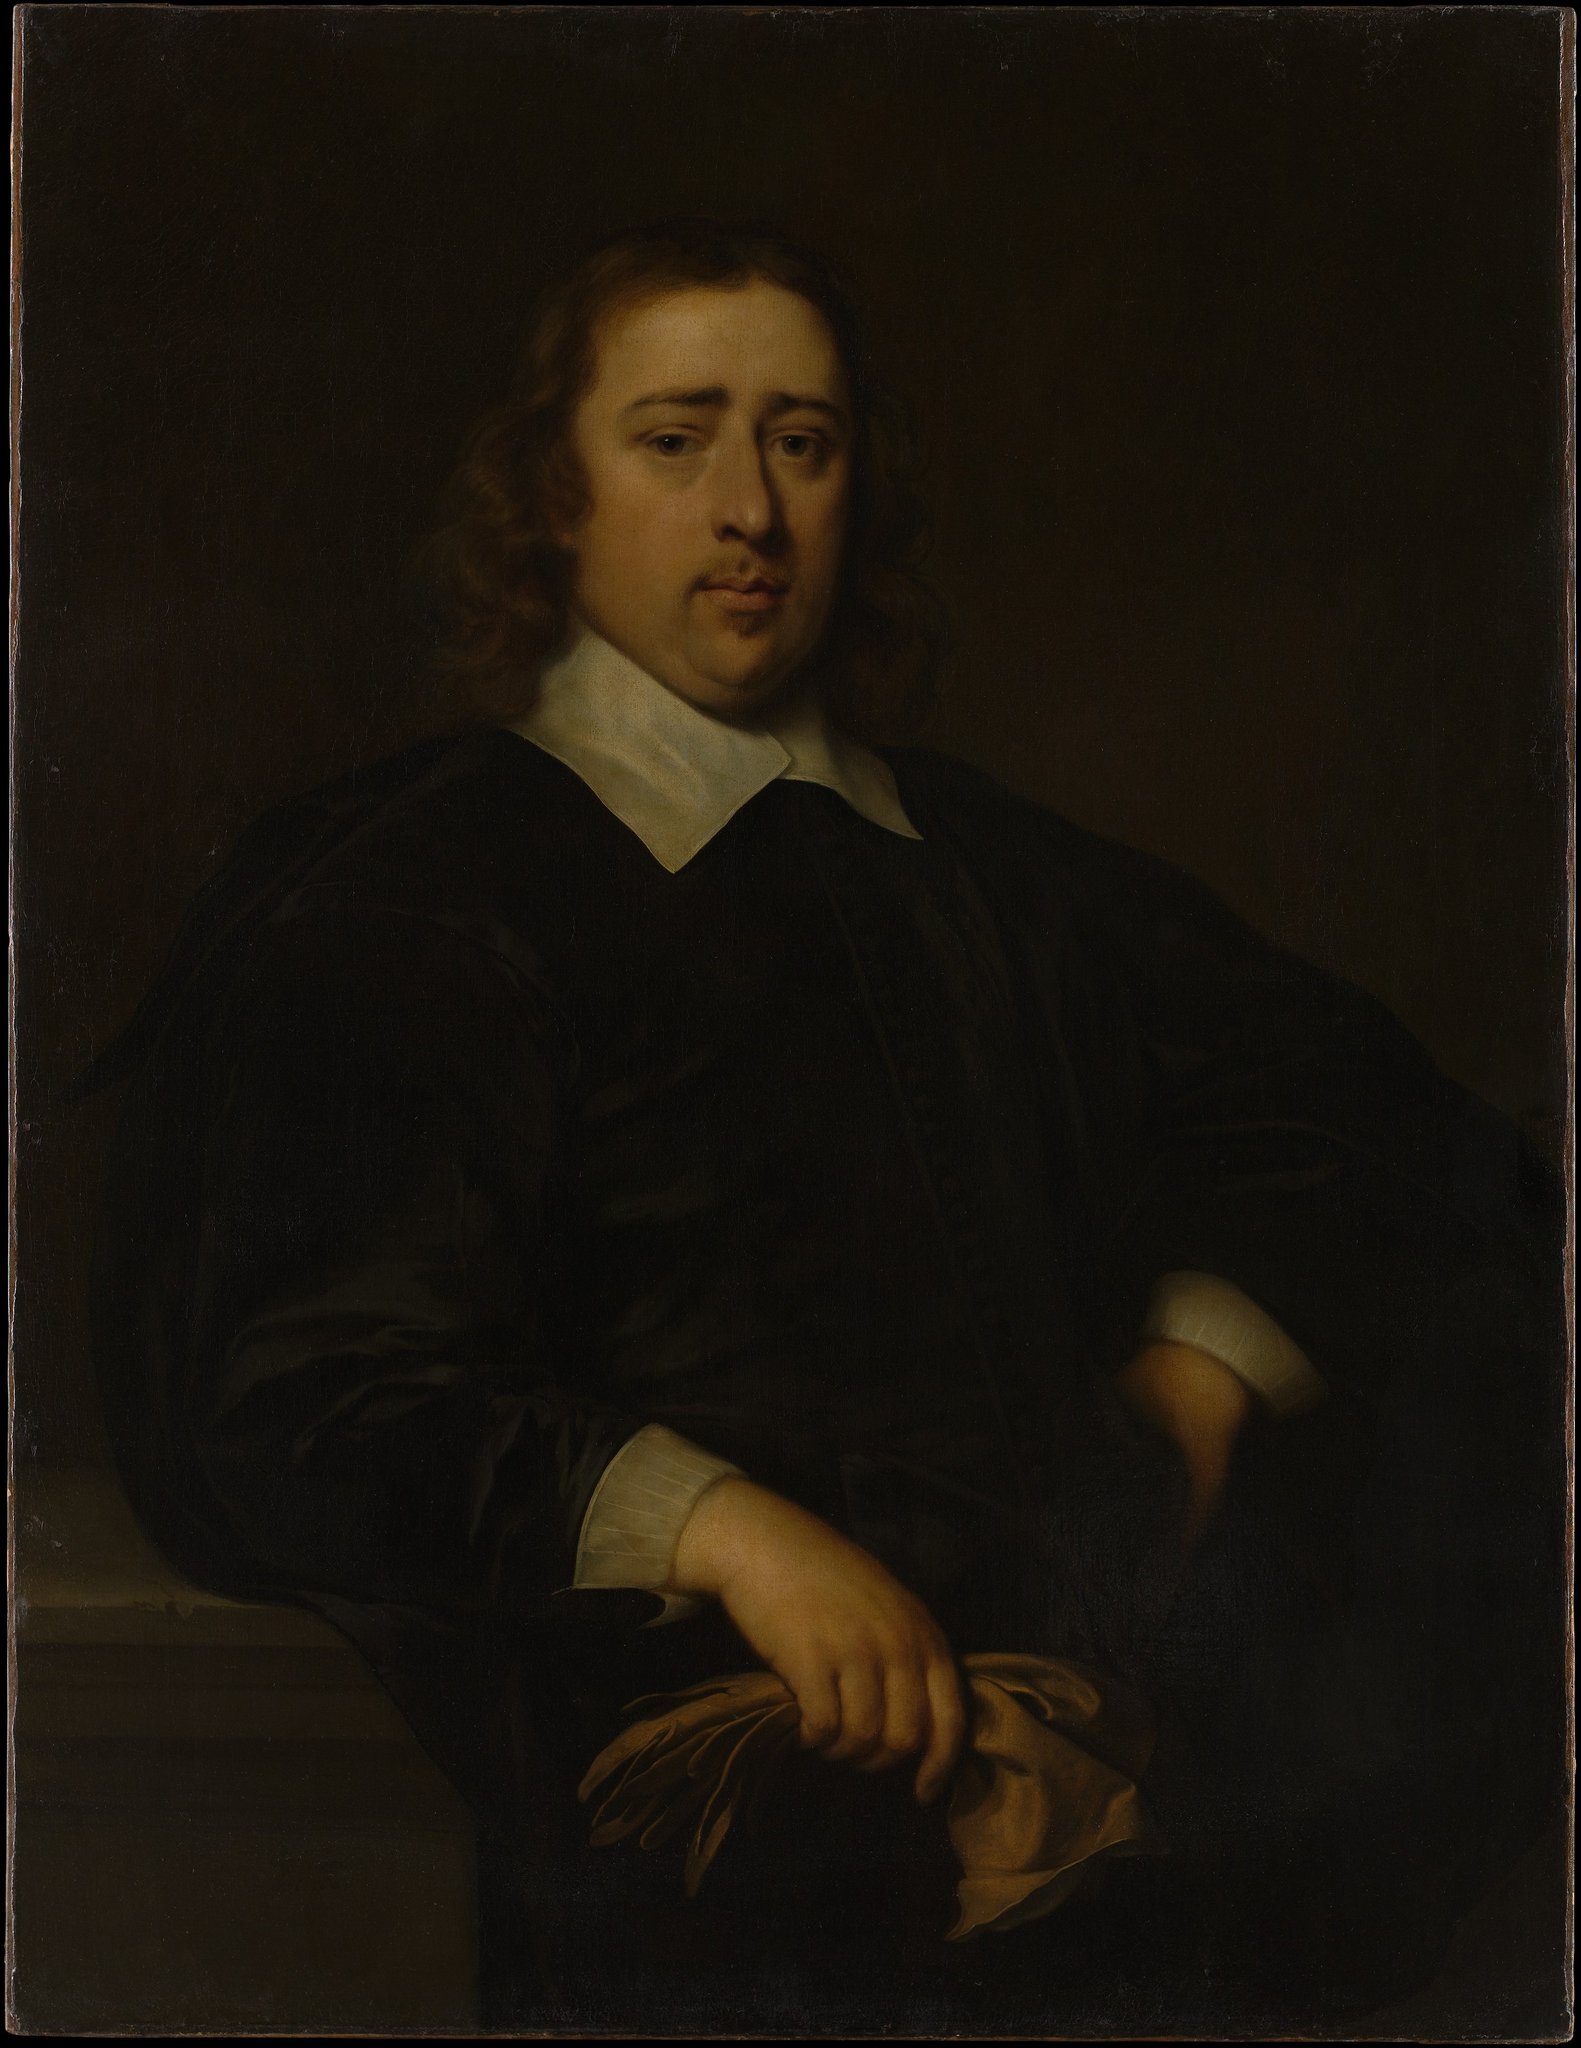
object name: painting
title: Portrait of a Man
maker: cornelis jonson van ceulen the elder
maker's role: artist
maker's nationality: dutch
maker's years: 1593-1661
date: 1648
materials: canvas, oil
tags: men,portraits